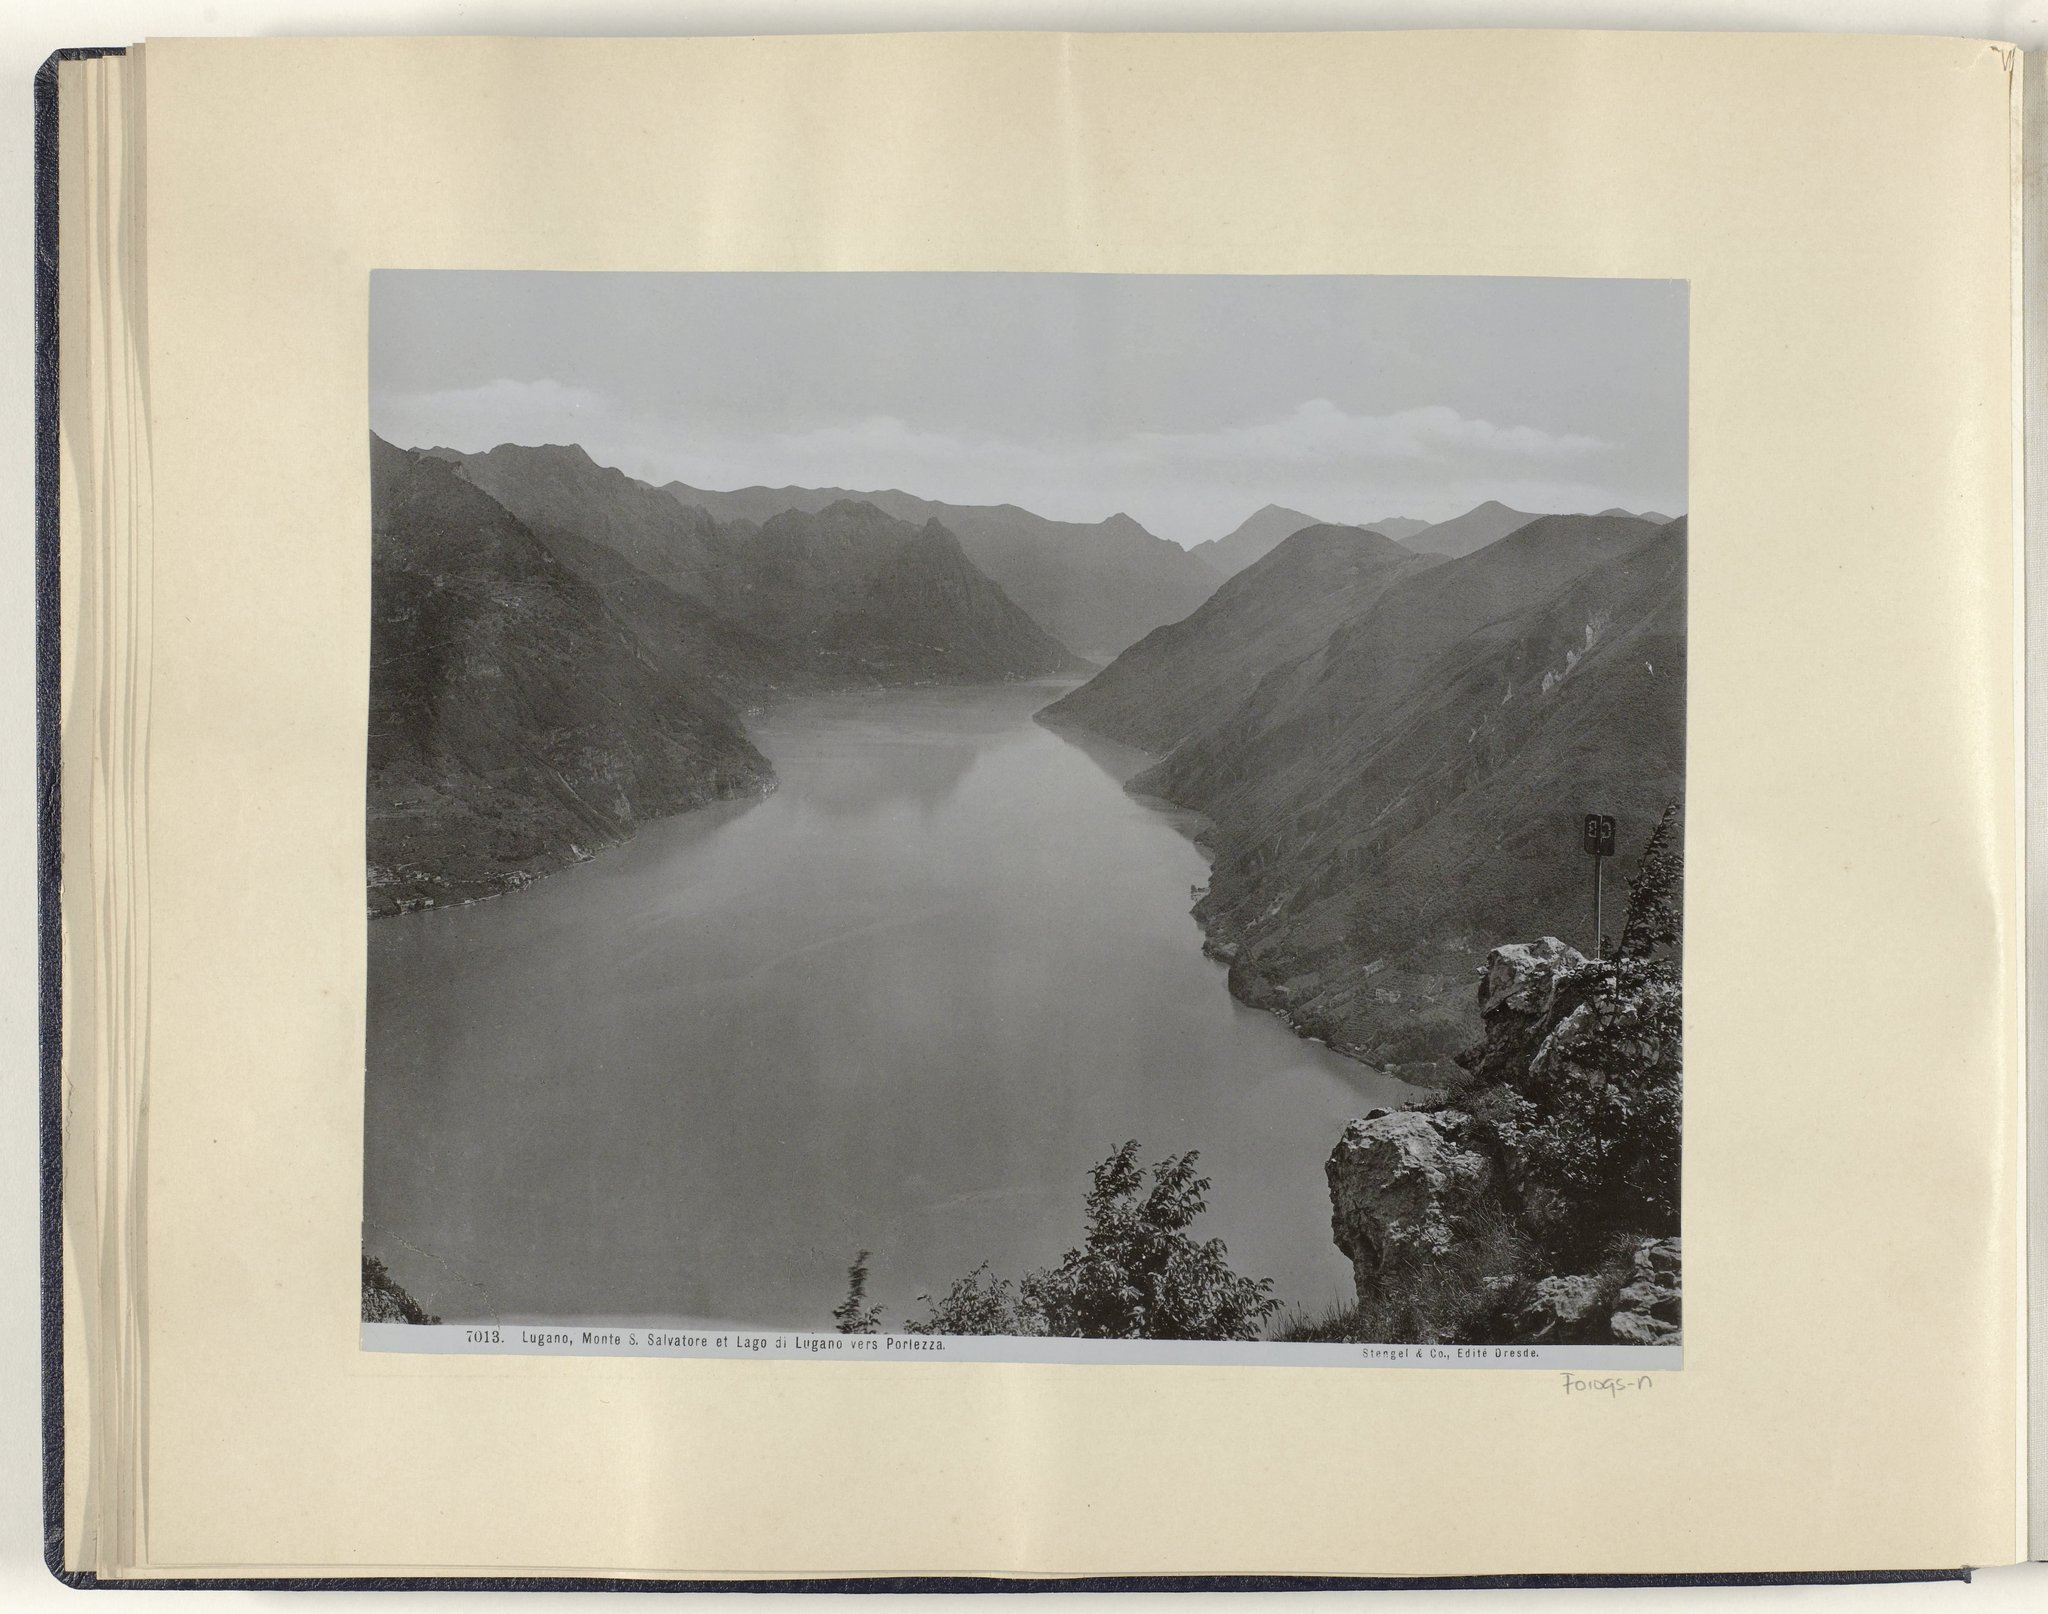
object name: photograph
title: Monte Salvatore en het Meer van Lugano gezien richting Porlezza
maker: Anonymous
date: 1897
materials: paper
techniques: photograph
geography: dresden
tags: lake, mountain-range, snow peaks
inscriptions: number: ‘7013’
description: Onderdeel van Reisalbum met foto's van bezienswaardigheden in Italië, Zwitserland en Nederlands-Indië.